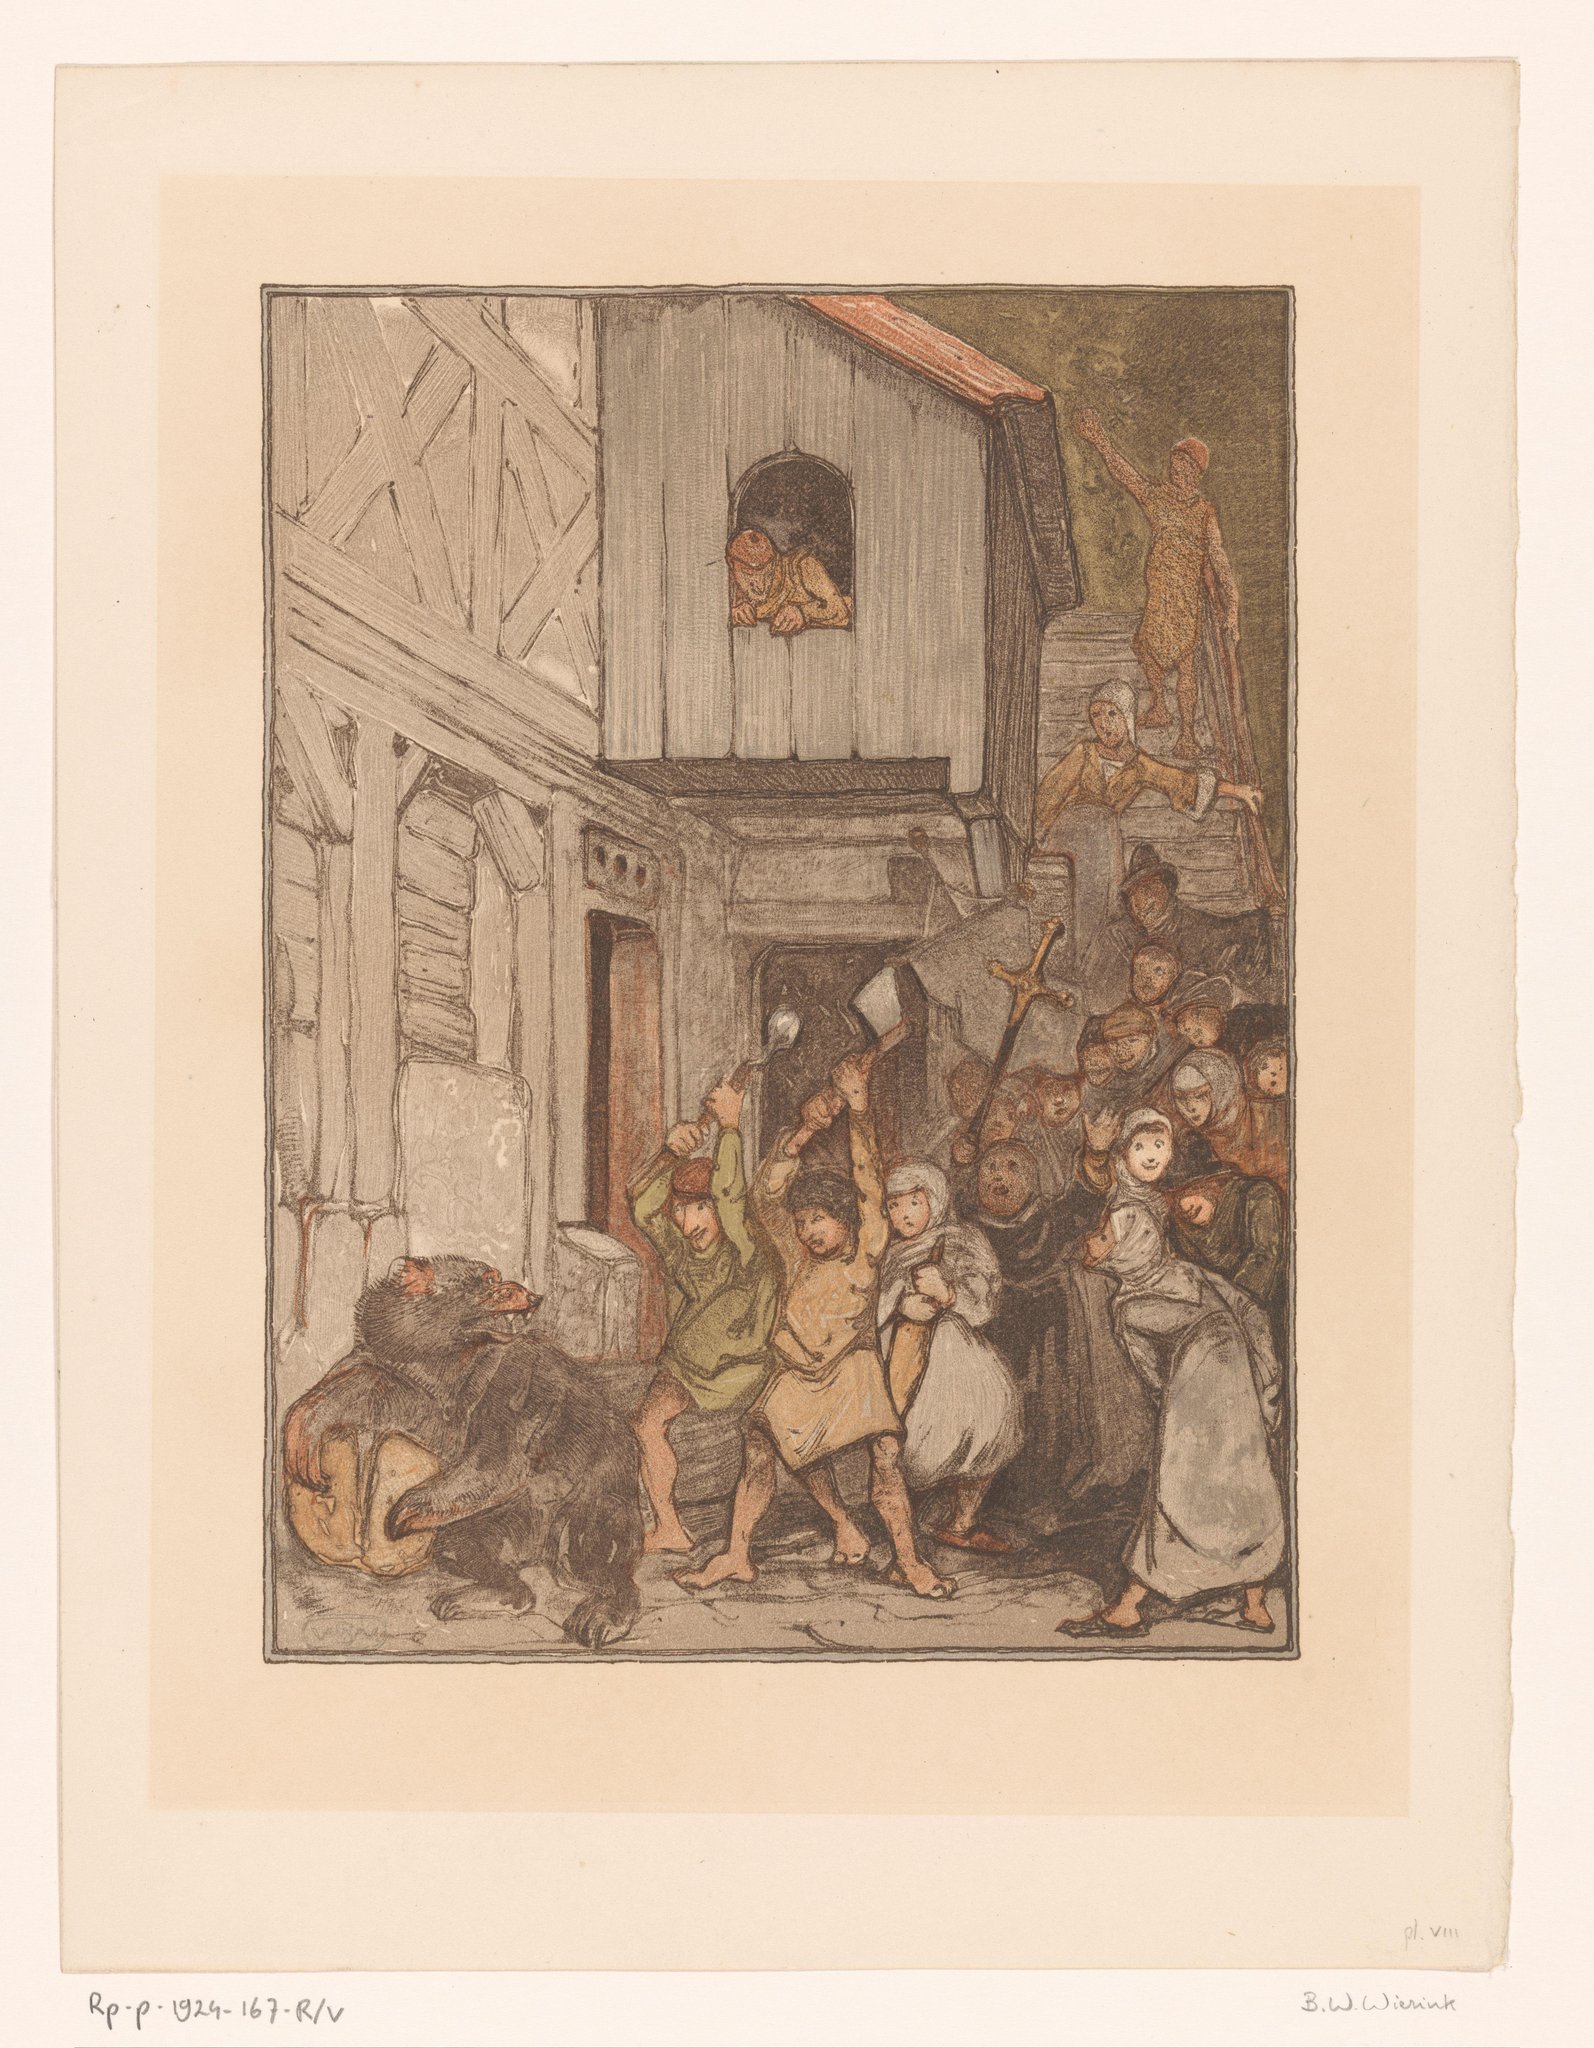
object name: print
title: Beer (Bruun) wordt aangevallen door een menigte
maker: bernard willem wierink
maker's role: draughtsman, print maker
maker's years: 1856-1939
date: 1910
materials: paper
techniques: lithograph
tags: fable of reynard the fox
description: Prent gebruikt in: Streuvels, Stijn (Frank Lateur). Reinaert de Vos naar verschillende uitgaven van het middeleeuwsche epos. Amsterdam: L.J. Veen, 1910.